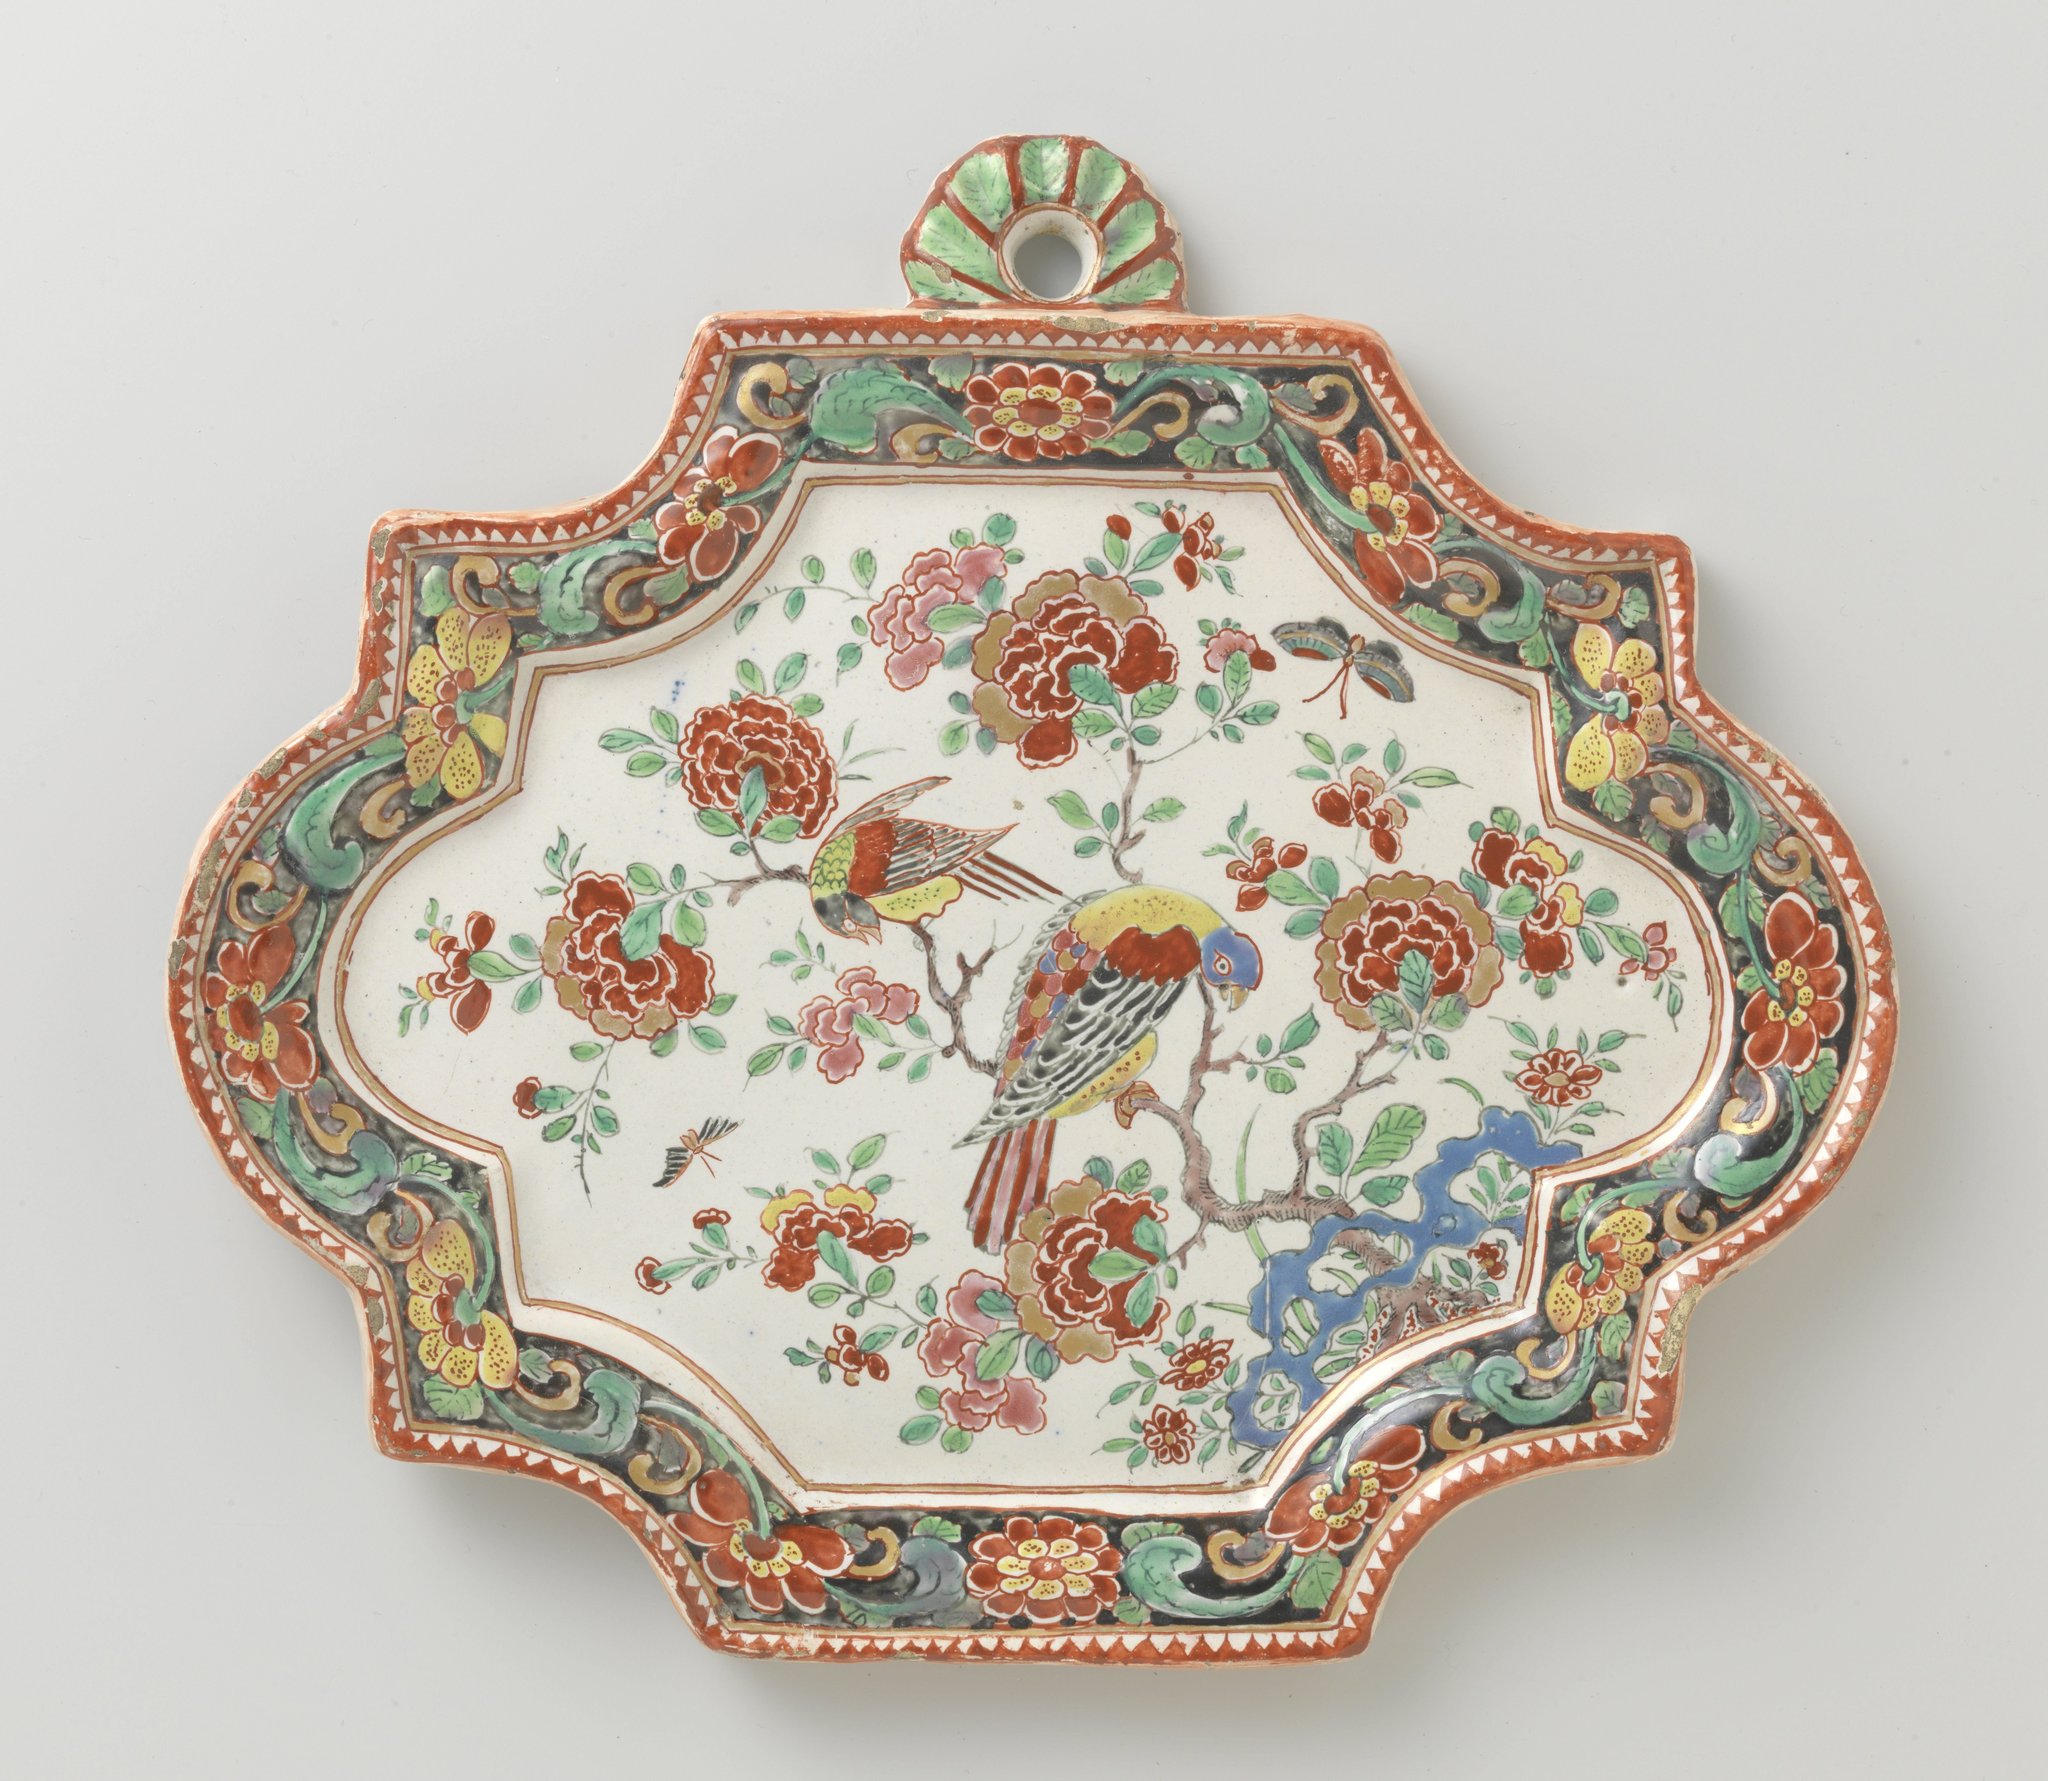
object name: plate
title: Plaque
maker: Anonymous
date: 1725-1750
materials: earthenware, glaze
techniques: kiln, painted, polychromy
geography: delft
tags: birds, flowers ~ ornament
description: Plaat met veelkleurig beschilderde vogels en bloemtakken.